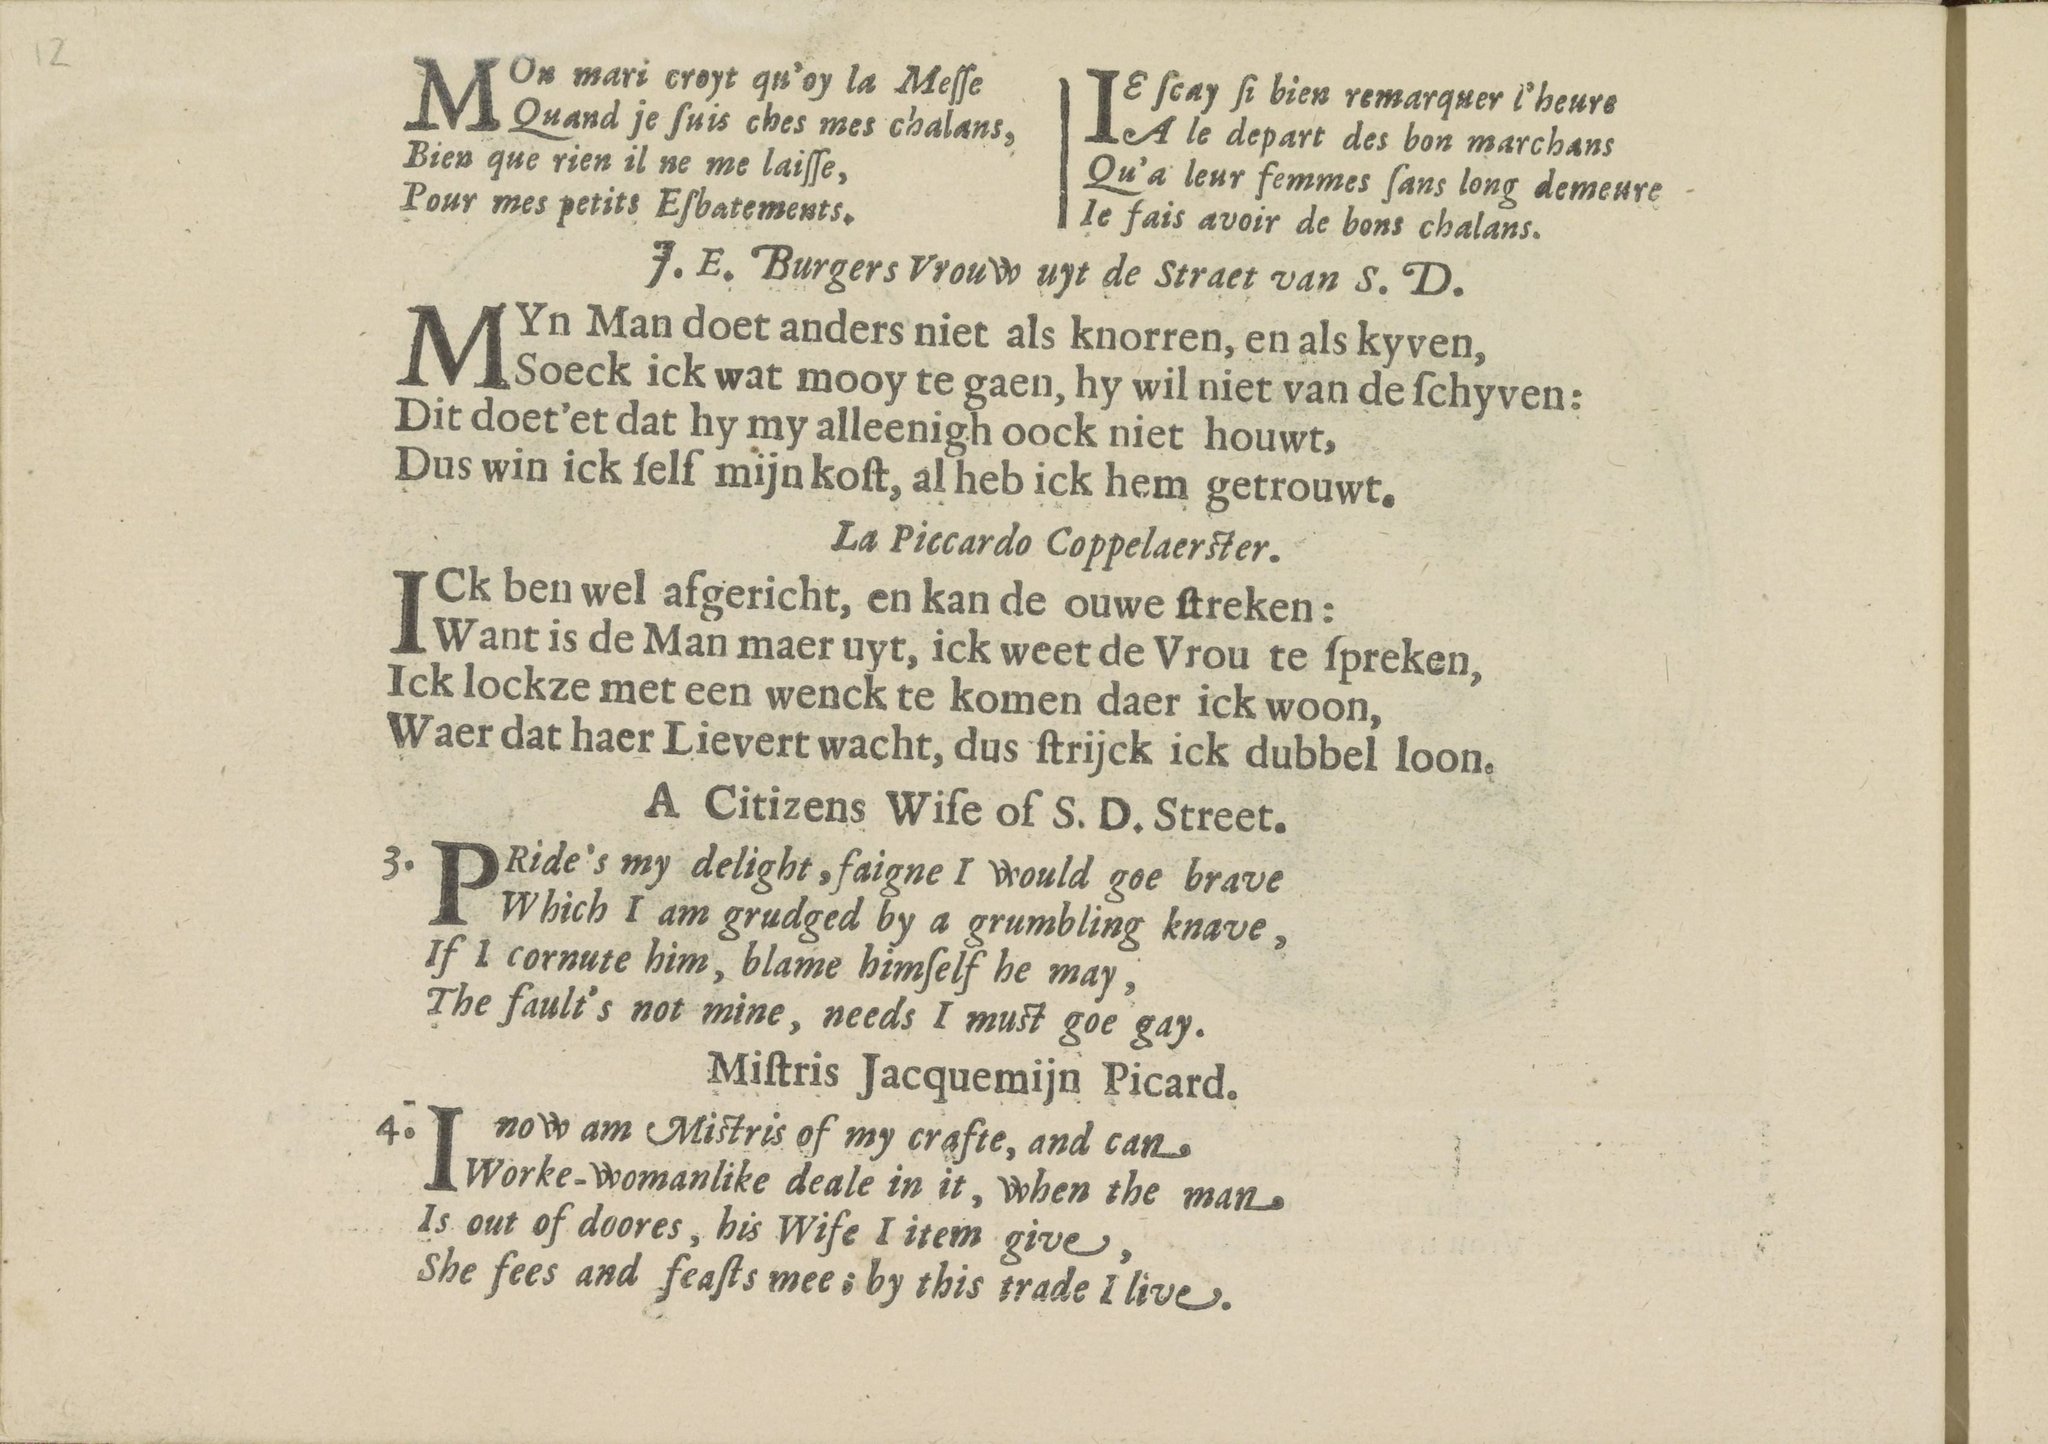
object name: album leaf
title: Kwatrijnen bij voorstellingen van een burgervrouw en een koppelaarster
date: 1641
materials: paper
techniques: letterpress printing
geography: amsterdam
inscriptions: date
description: Drie keer twee kwatrijnen in het Frans, Nederlands en Engels bij voorstellingen van een burgervrouw en een koppelaarster. Het blad maakt deel uit van een album.